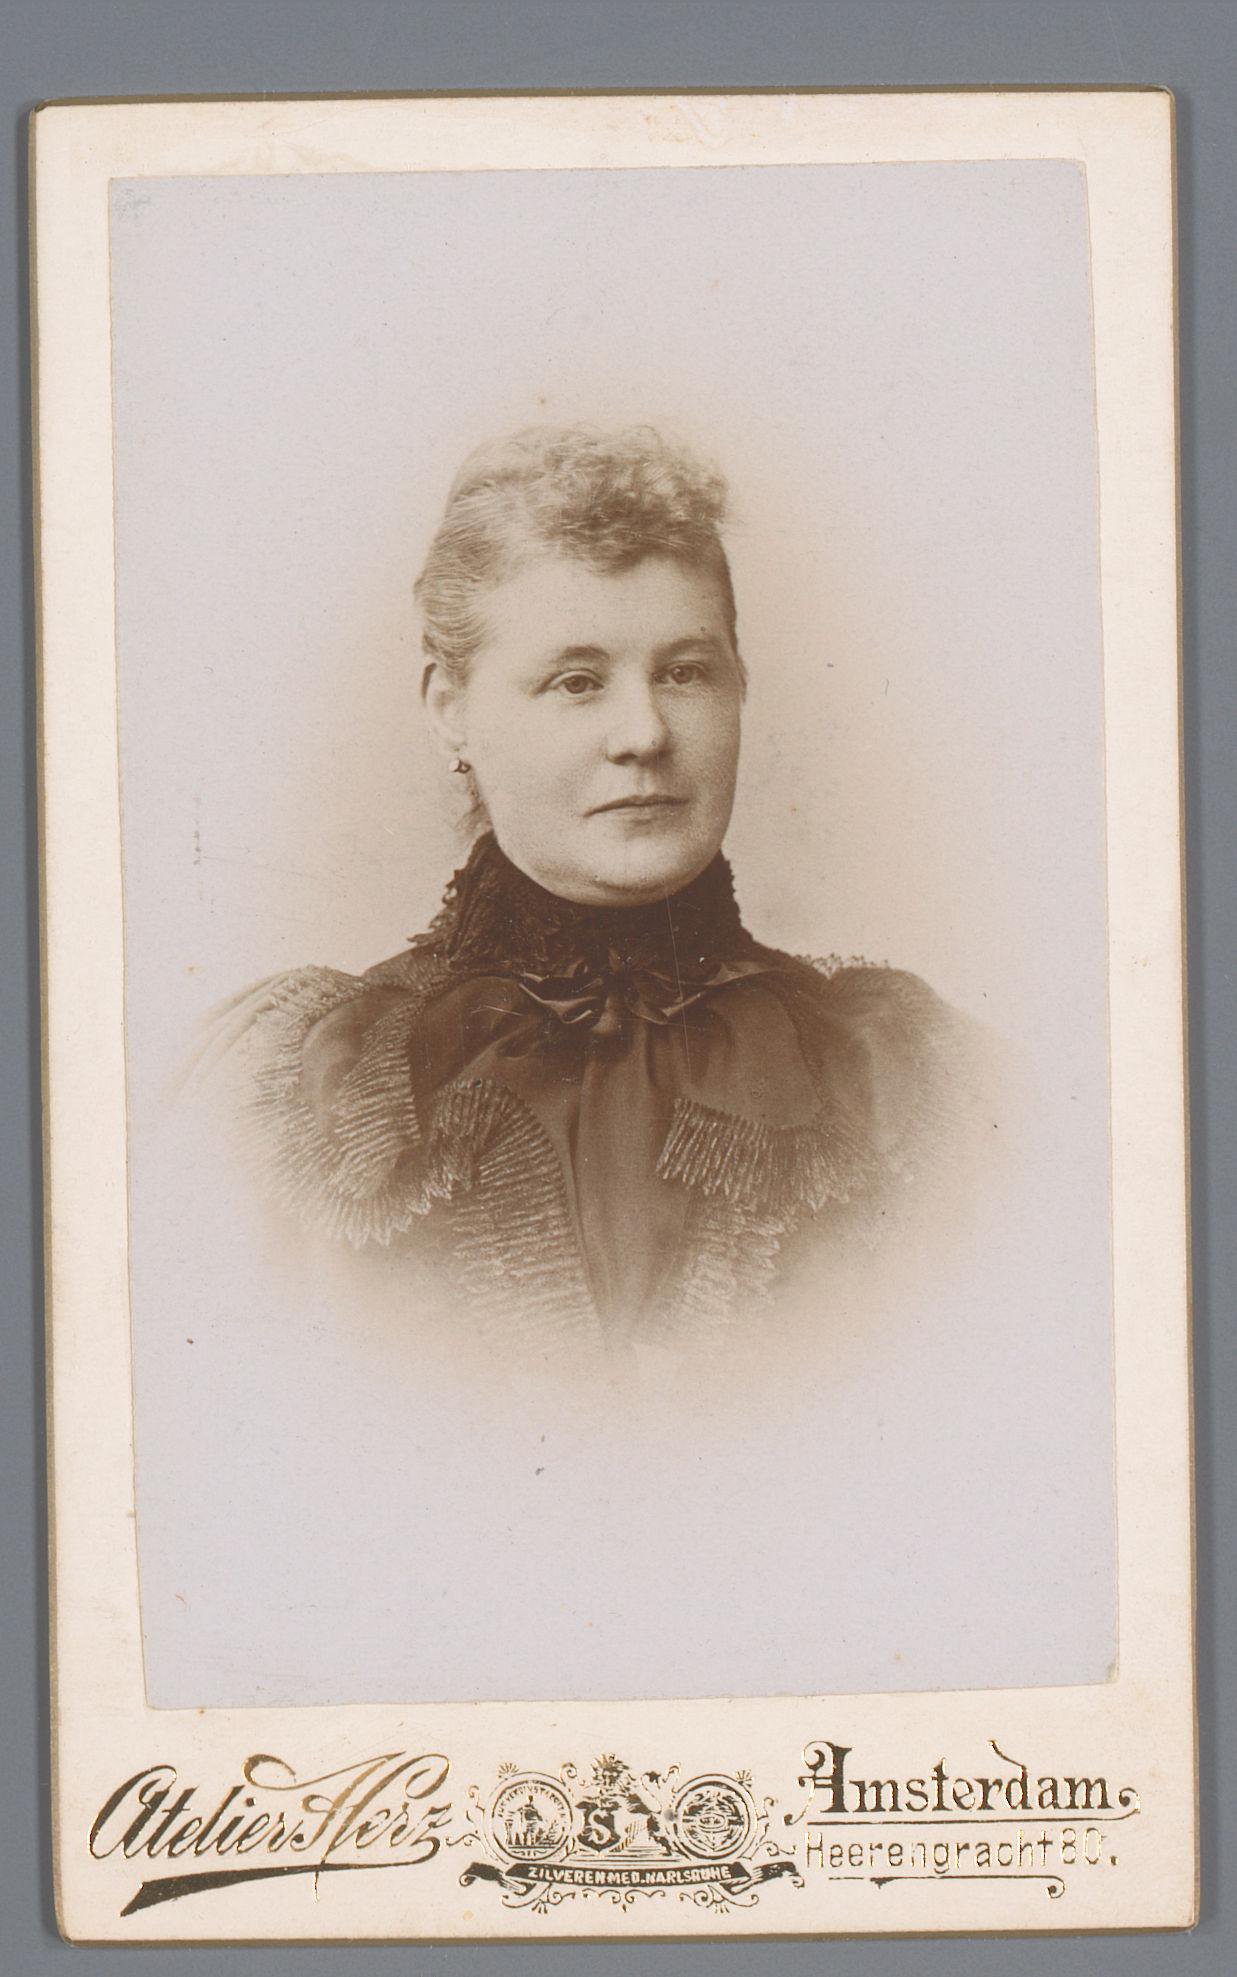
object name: carte de visite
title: Portret van Ida Keyser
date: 1892-1910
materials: cardboard, photographic support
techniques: collodion silver print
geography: amsterdam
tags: historical persons, amsterdam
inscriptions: annotation: ‘Ida Keyser’, workshop stamp: ‘Photographie/ Atelier Herz/ Heerengracht 80 en Heerenstraat 4, Amsterdam’, number: ‘7/2B’